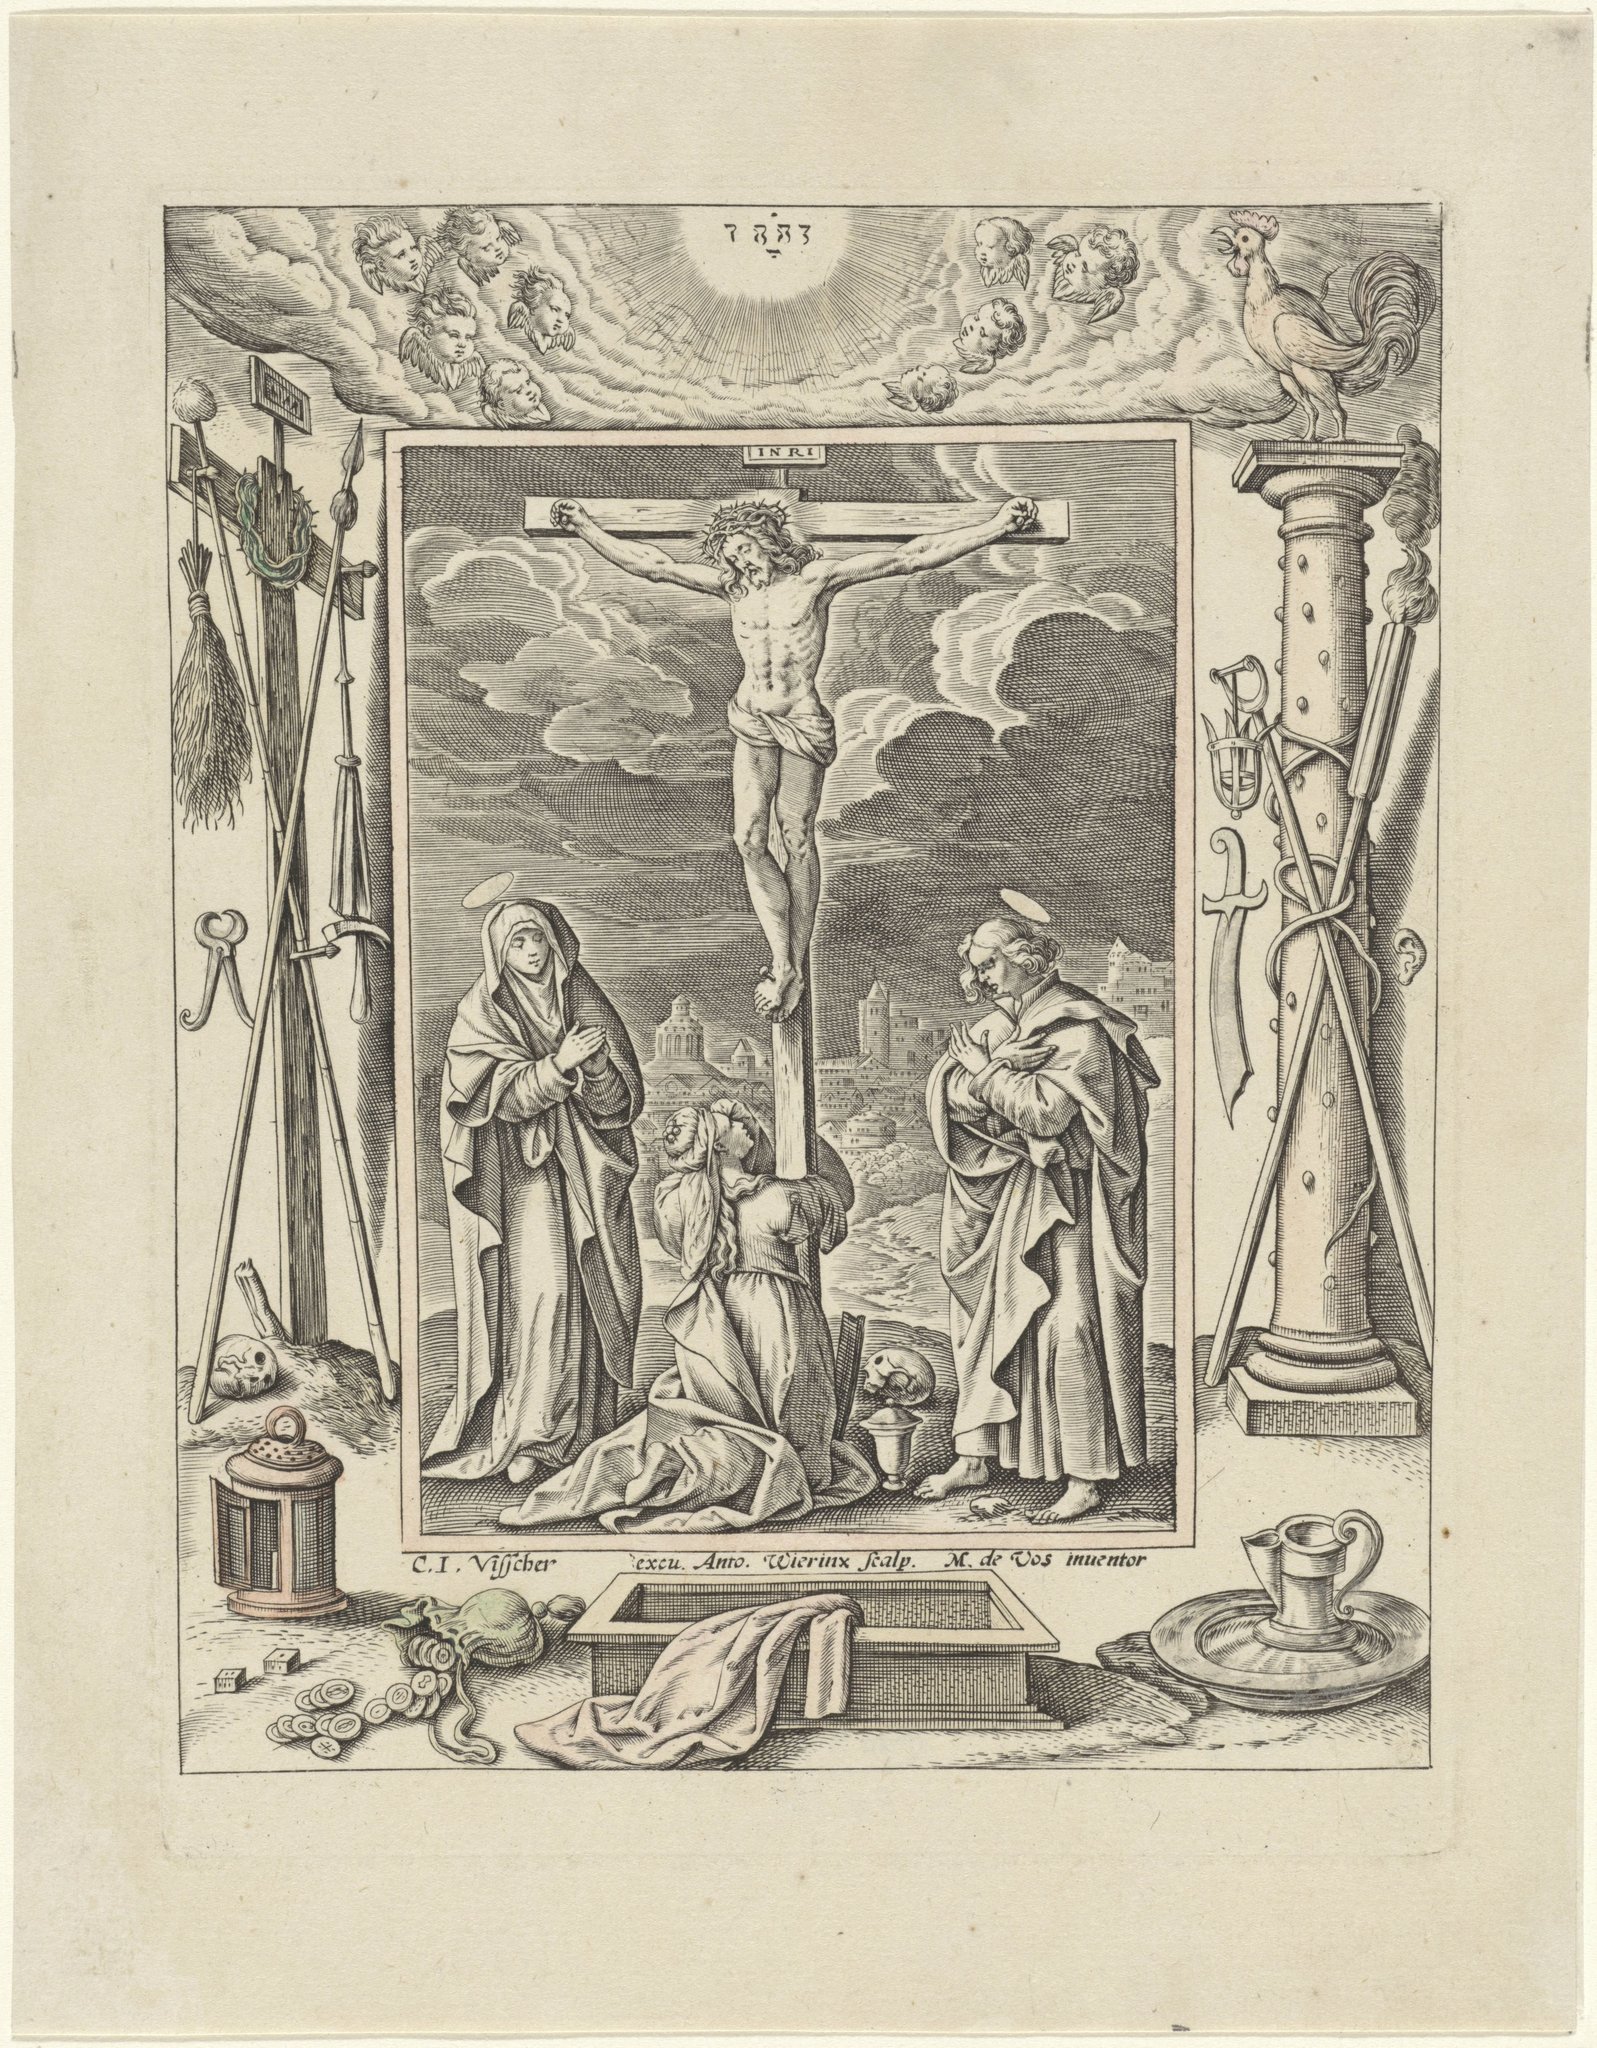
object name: print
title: Kruisiging van Christus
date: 1582-1586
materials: paper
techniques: engraving, hand coloring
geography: amsterdam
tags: comprehensive representations of the events on golgotha during christ's hanging on the cross, no particular event emphasized, single instruments of the passion, tetragram (in roman or hebrew script) ~ symbol of god the father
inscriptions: collector's mark: Lugt 2228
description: De kruisdood van Christus op de berg Golgota. Onder het kruis bevinden zich Maria Magdalena, Maria en de Heilige Johannes. De voorstelling is gevat in een ornamentele omlijsting die is gedecoreerd met de passiewerktuigen en bovenaan het tetragram omringd door cherubijnen.